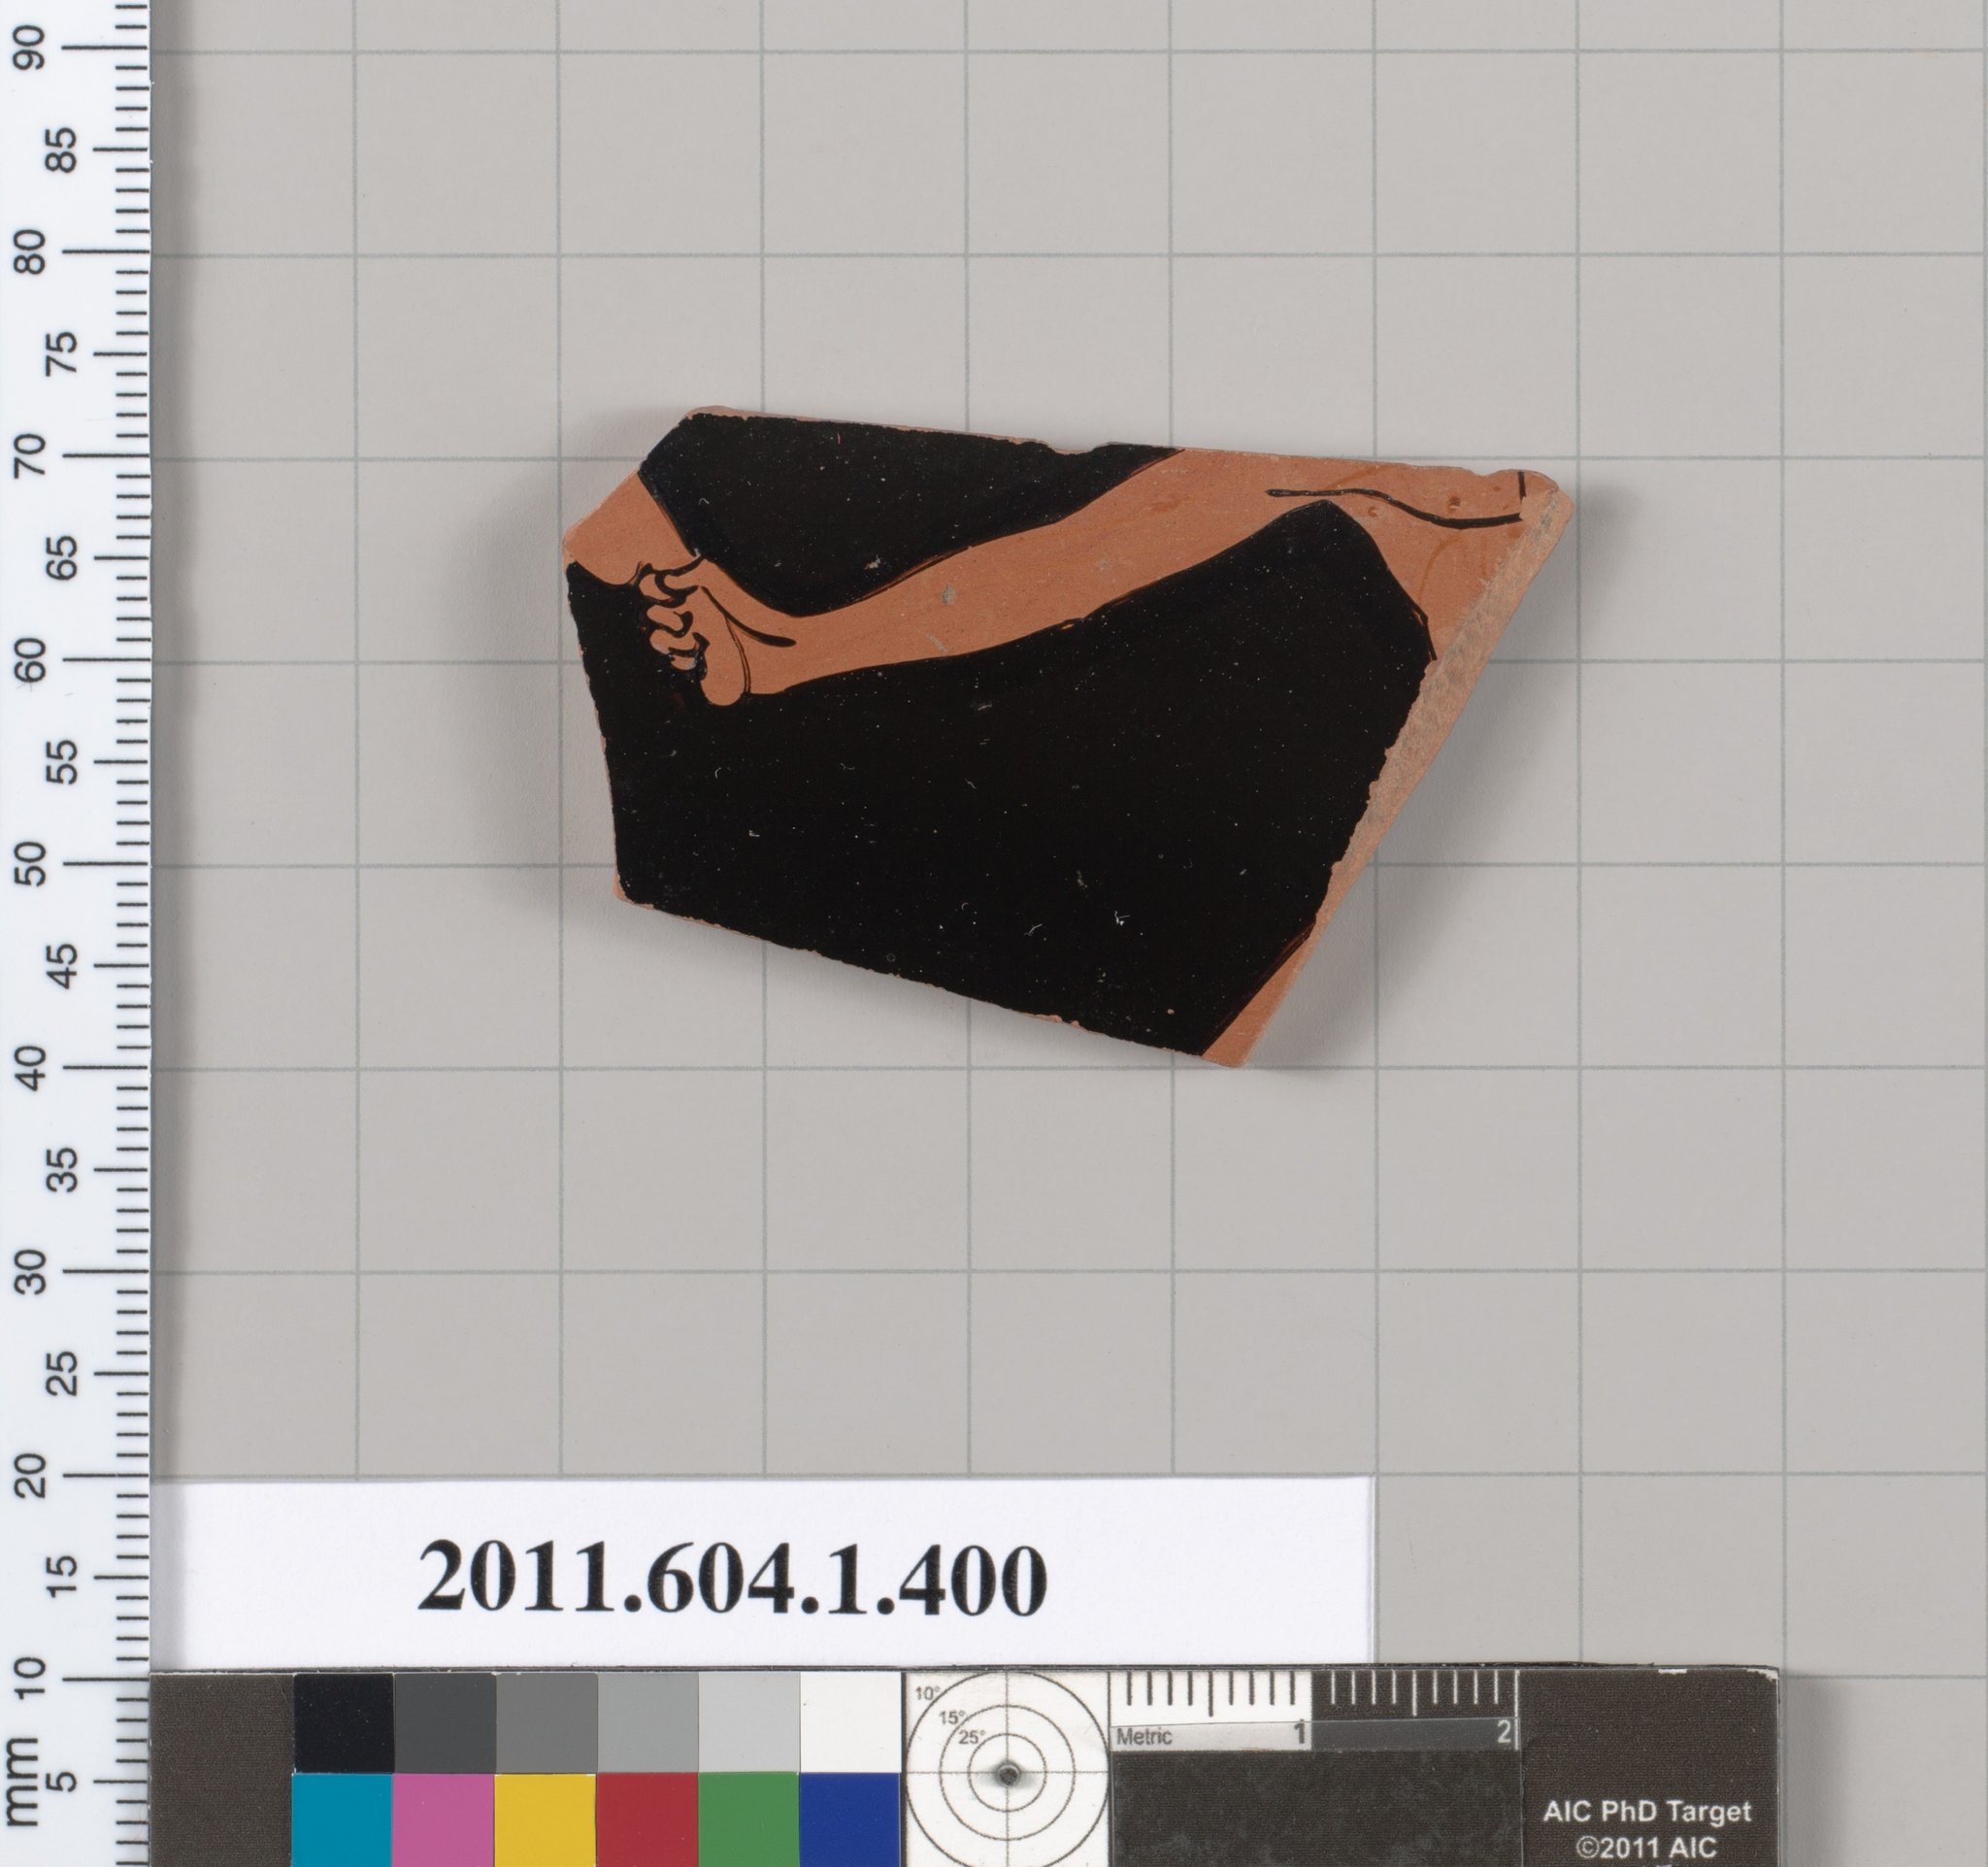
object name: kylix fragment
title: Terracotta fragment of a kylix (drinking cup)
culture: greek, attic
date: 475-451 BCE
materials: terracotta